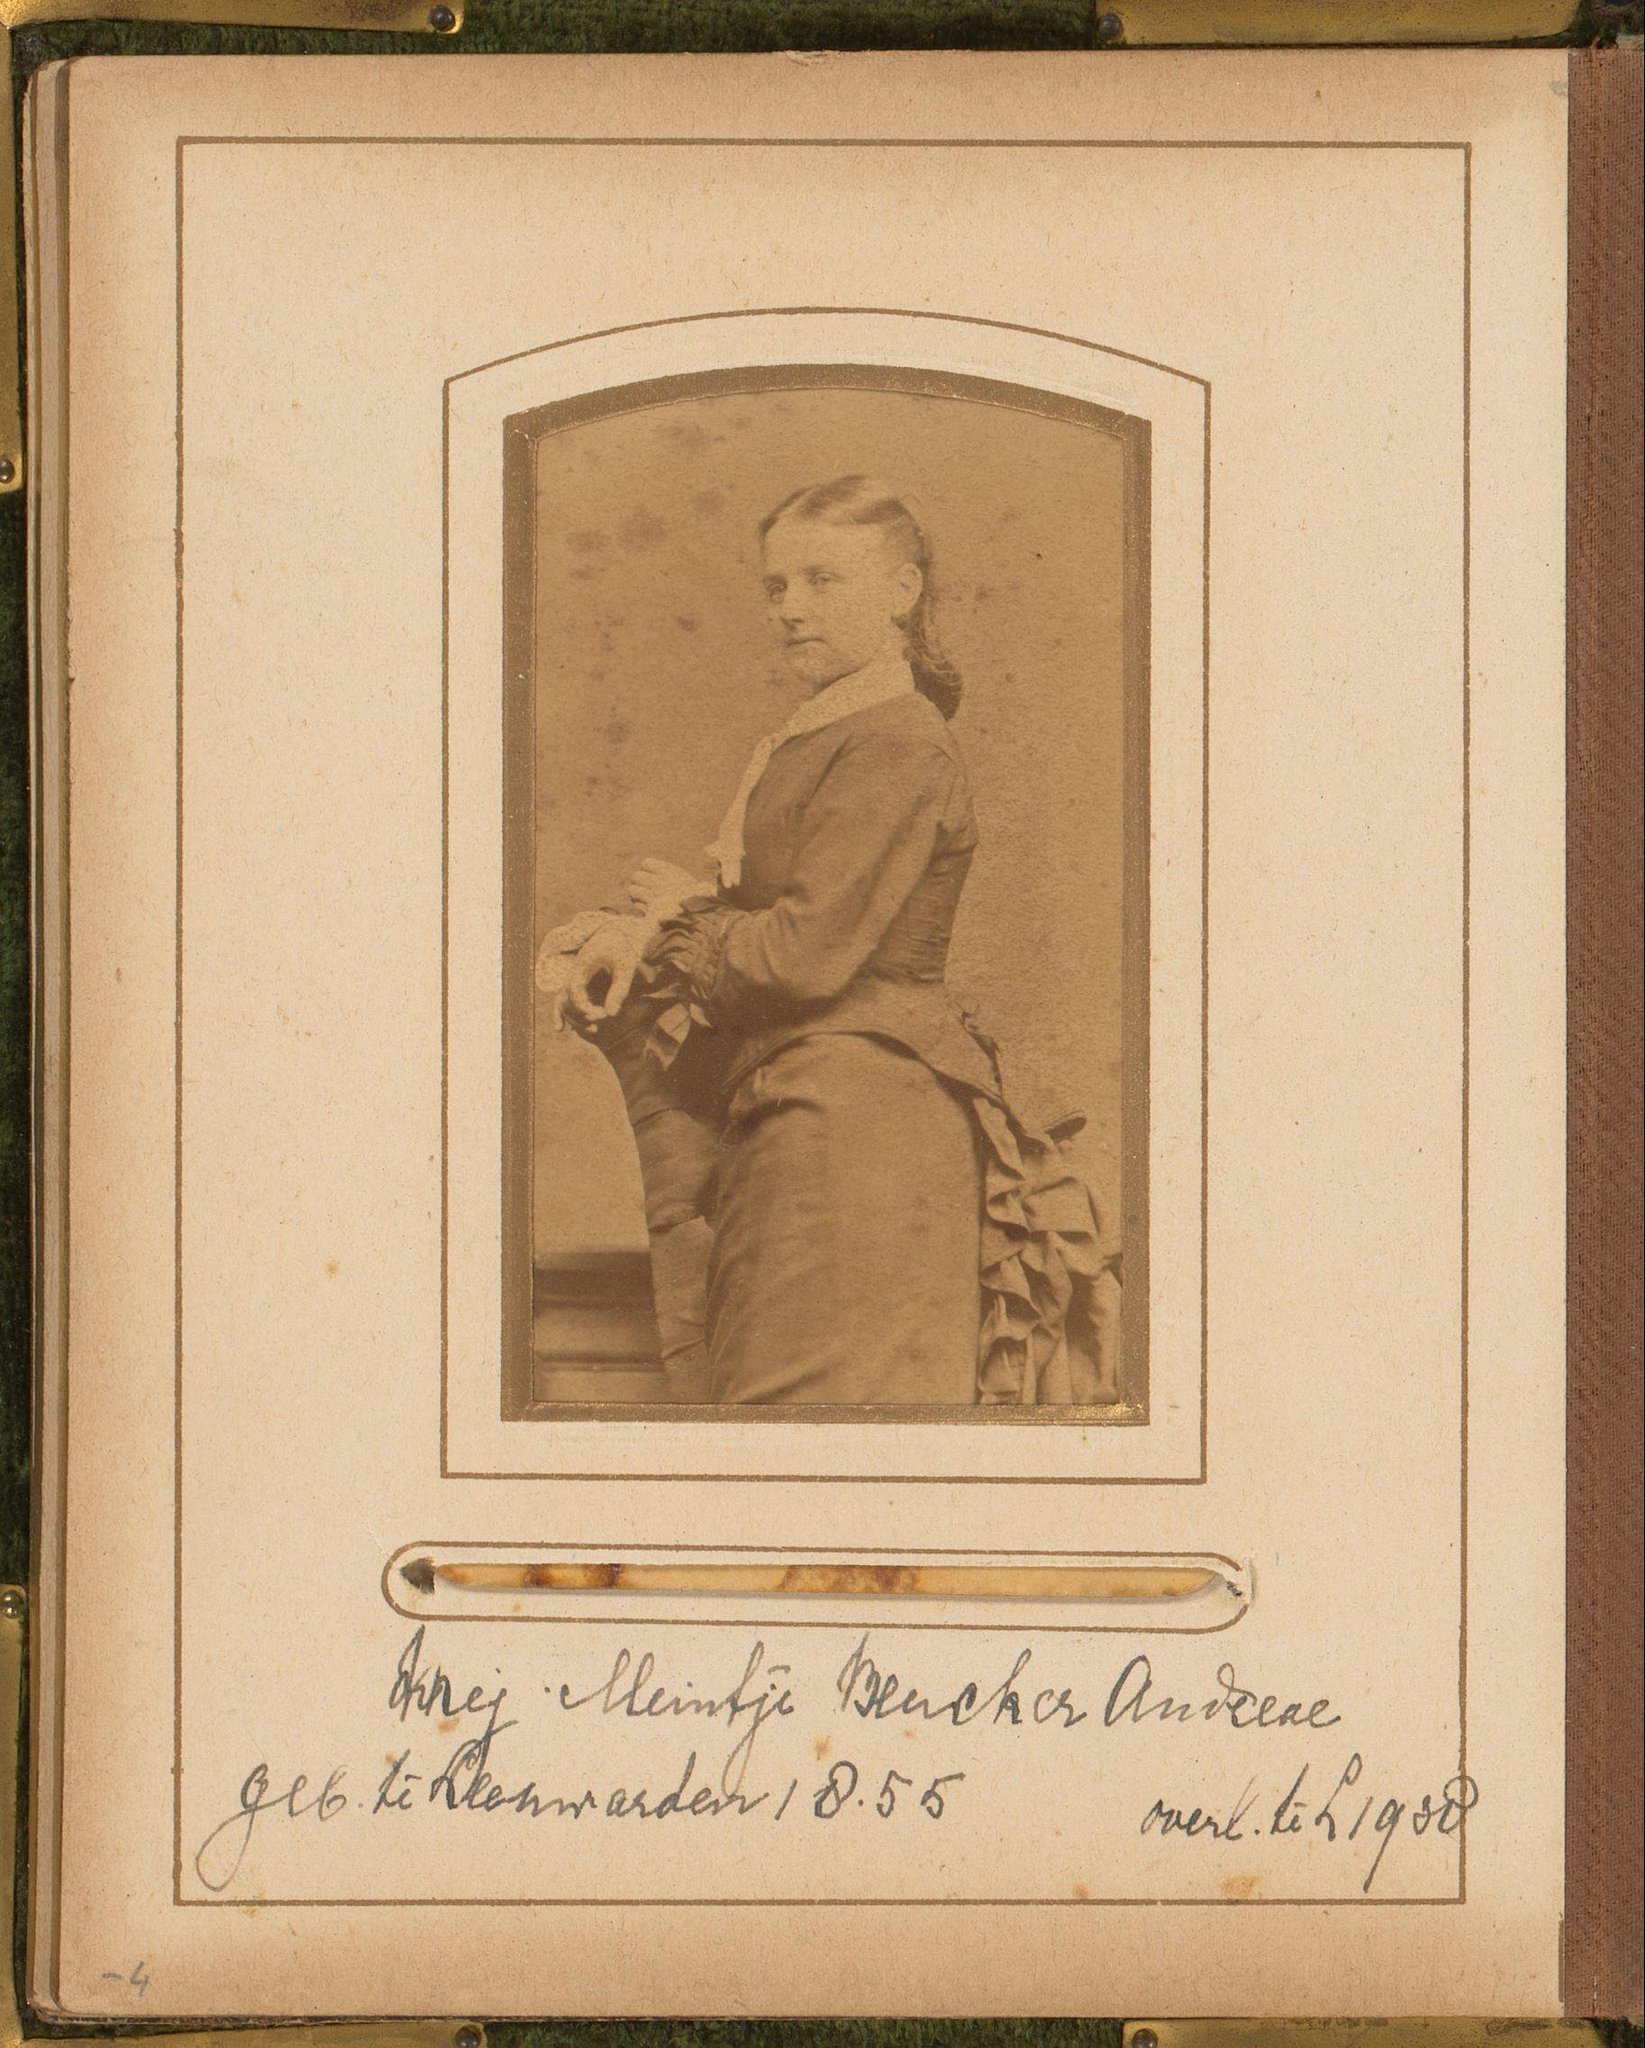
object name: album leaf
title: Portret van Meintje Beucker Andreae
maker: Anonymous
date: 1860-1875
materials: cardboard, paper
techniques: albumen print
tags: adolescent, young woman, maiden, historical persons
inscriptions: inscription: ‘Mej. Meintje Beucker Andreae/ geb. te Leeuwarden 1855/ overl. te L 1938’